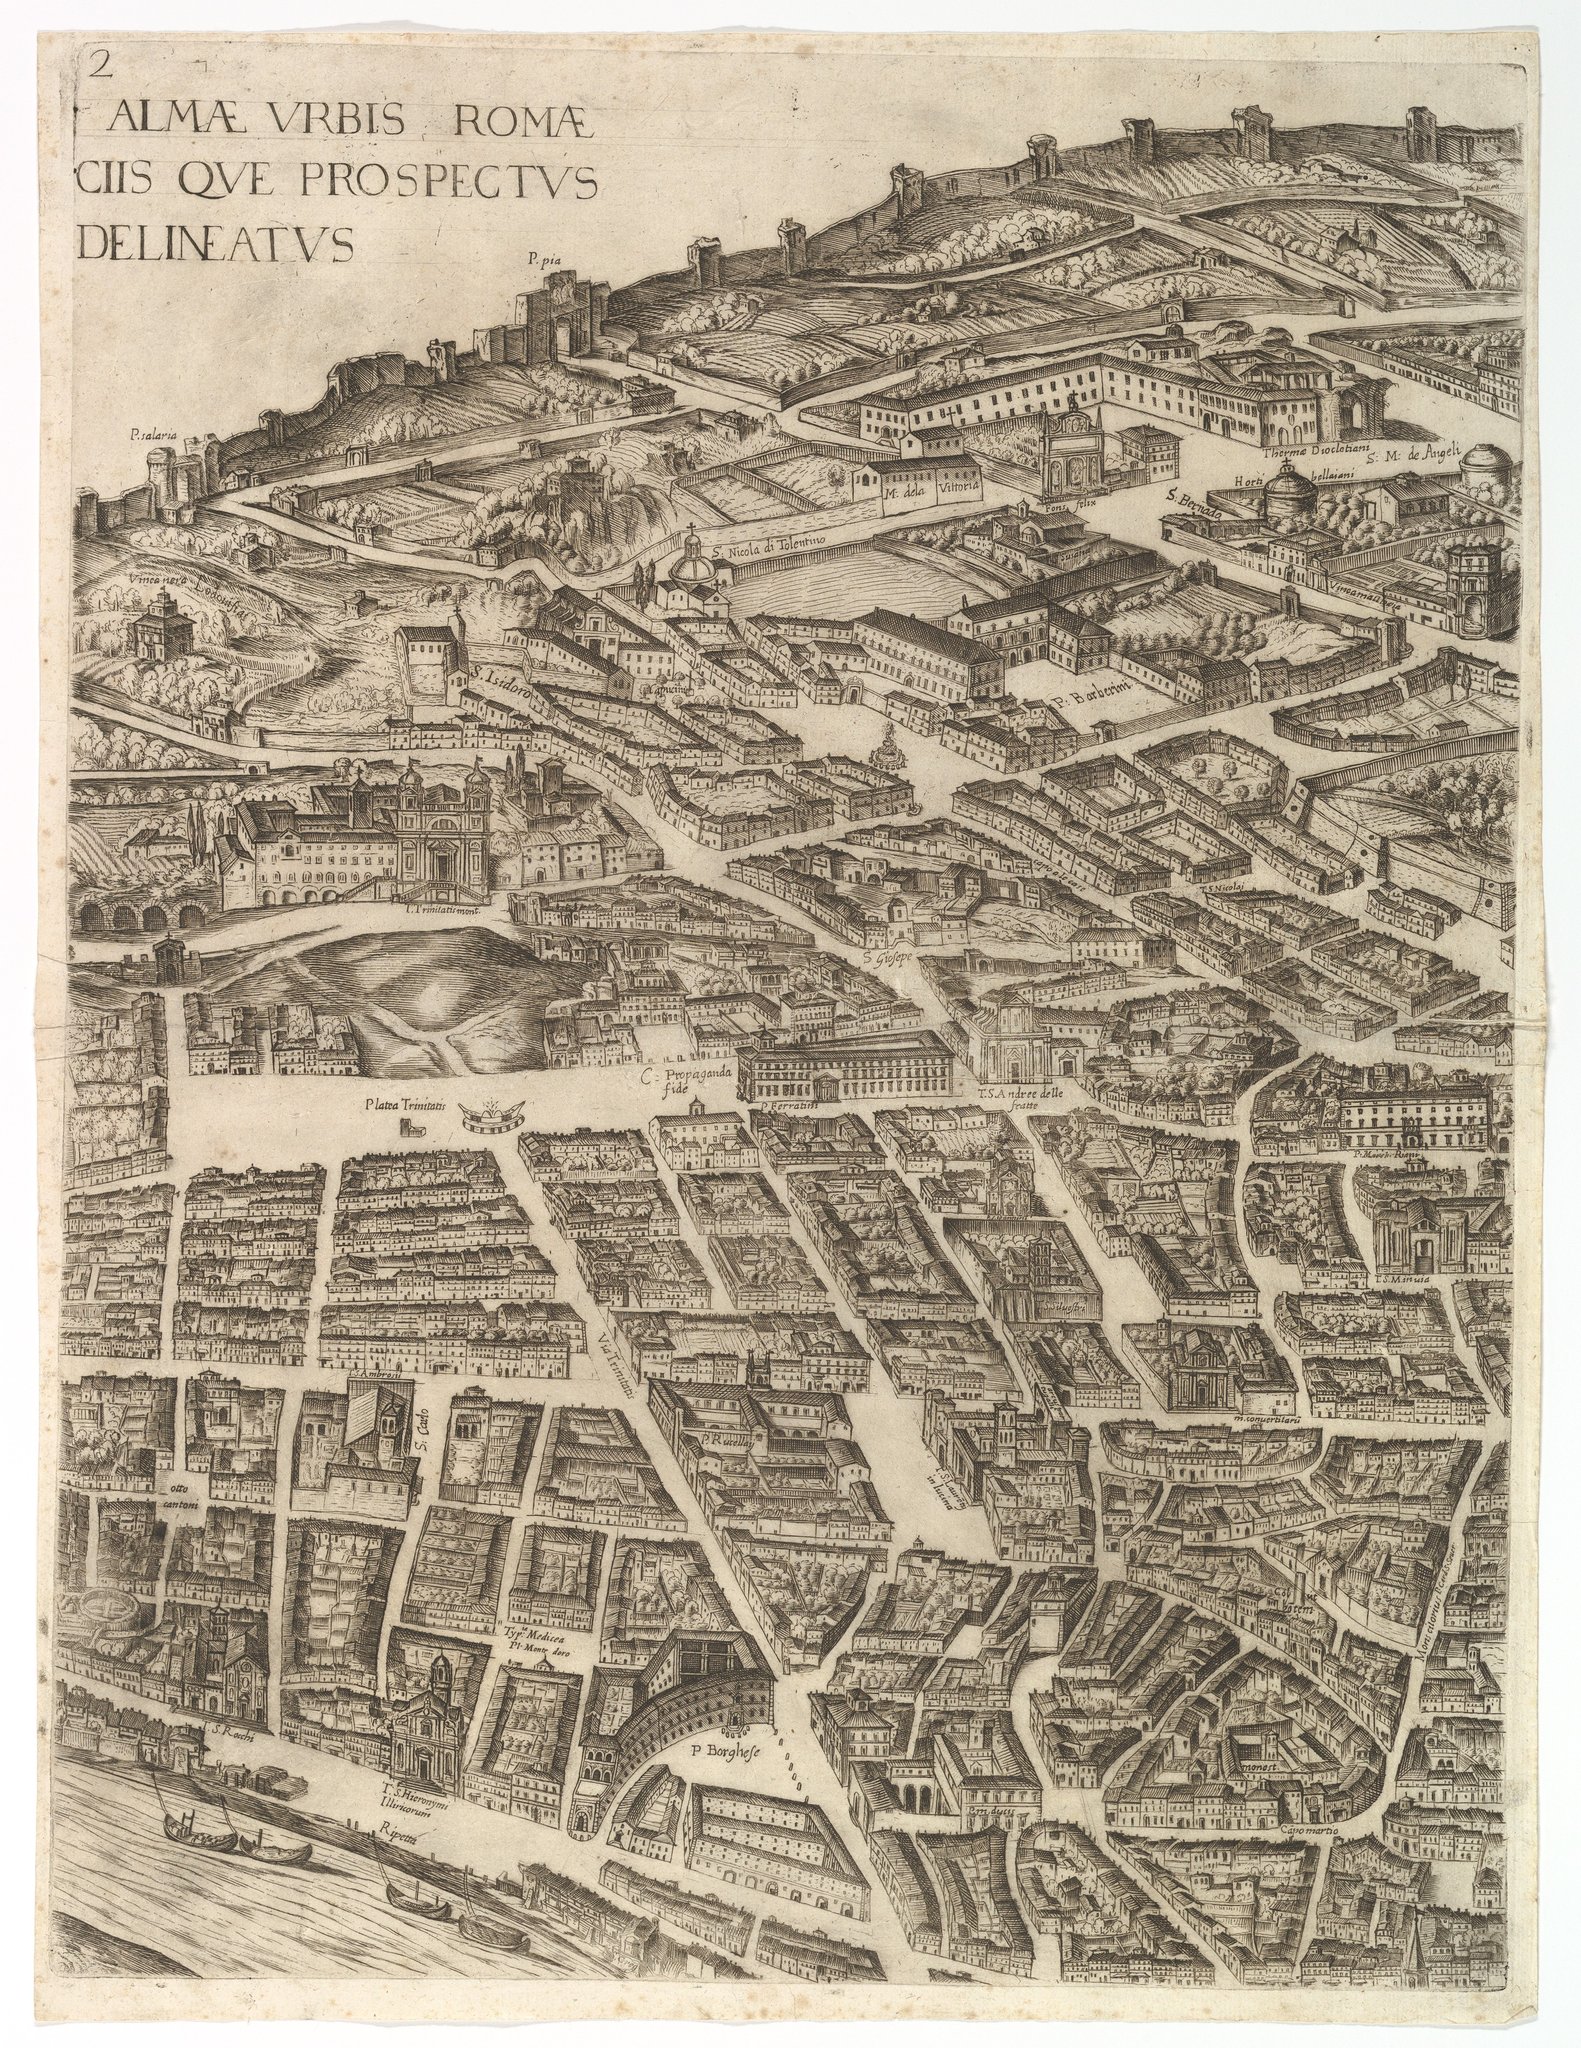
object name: print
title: Plan of the City of Rome. Part 2 with the Trinità dei Monti, Palazzo Borghese and the Baths of Diocletian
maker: antonio tempesta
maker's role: artist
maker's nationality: italian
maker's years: 1555-1630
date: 1645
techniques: engraving, etching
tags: cities,maps,rome